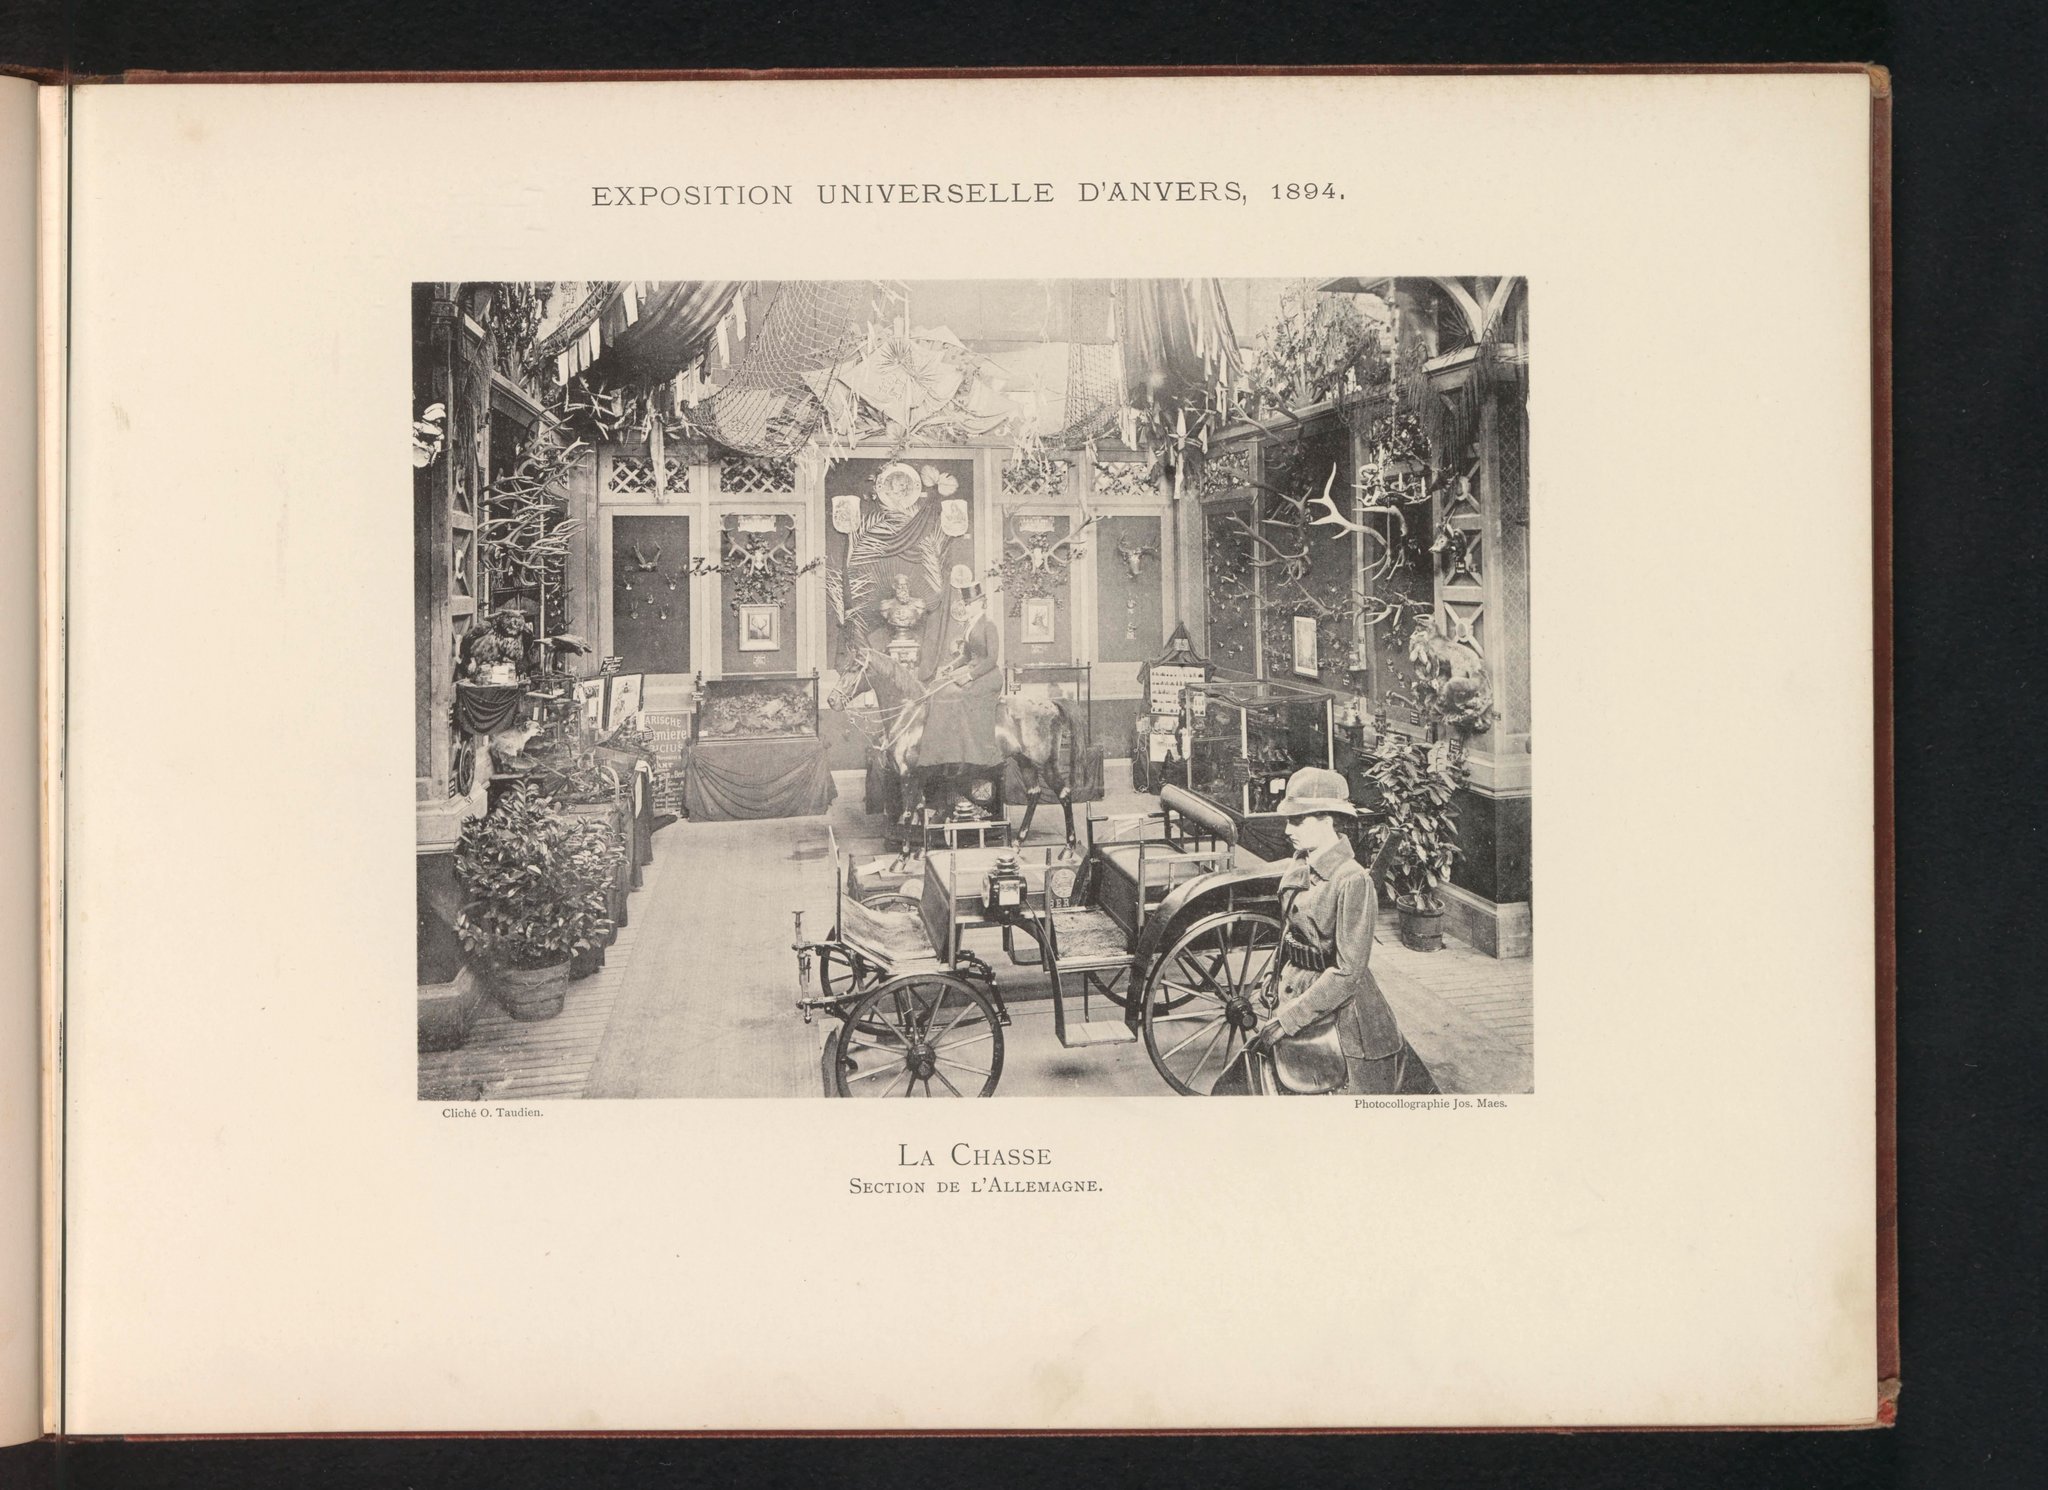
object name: photomechanical print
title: La Chasse Section de l'Allemagne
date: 1894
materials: paper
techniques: photograph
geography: antwerp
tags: hunting, chase, world fair, world exhibition, spoils of the hunt, game, venison, collection, exhibition, show